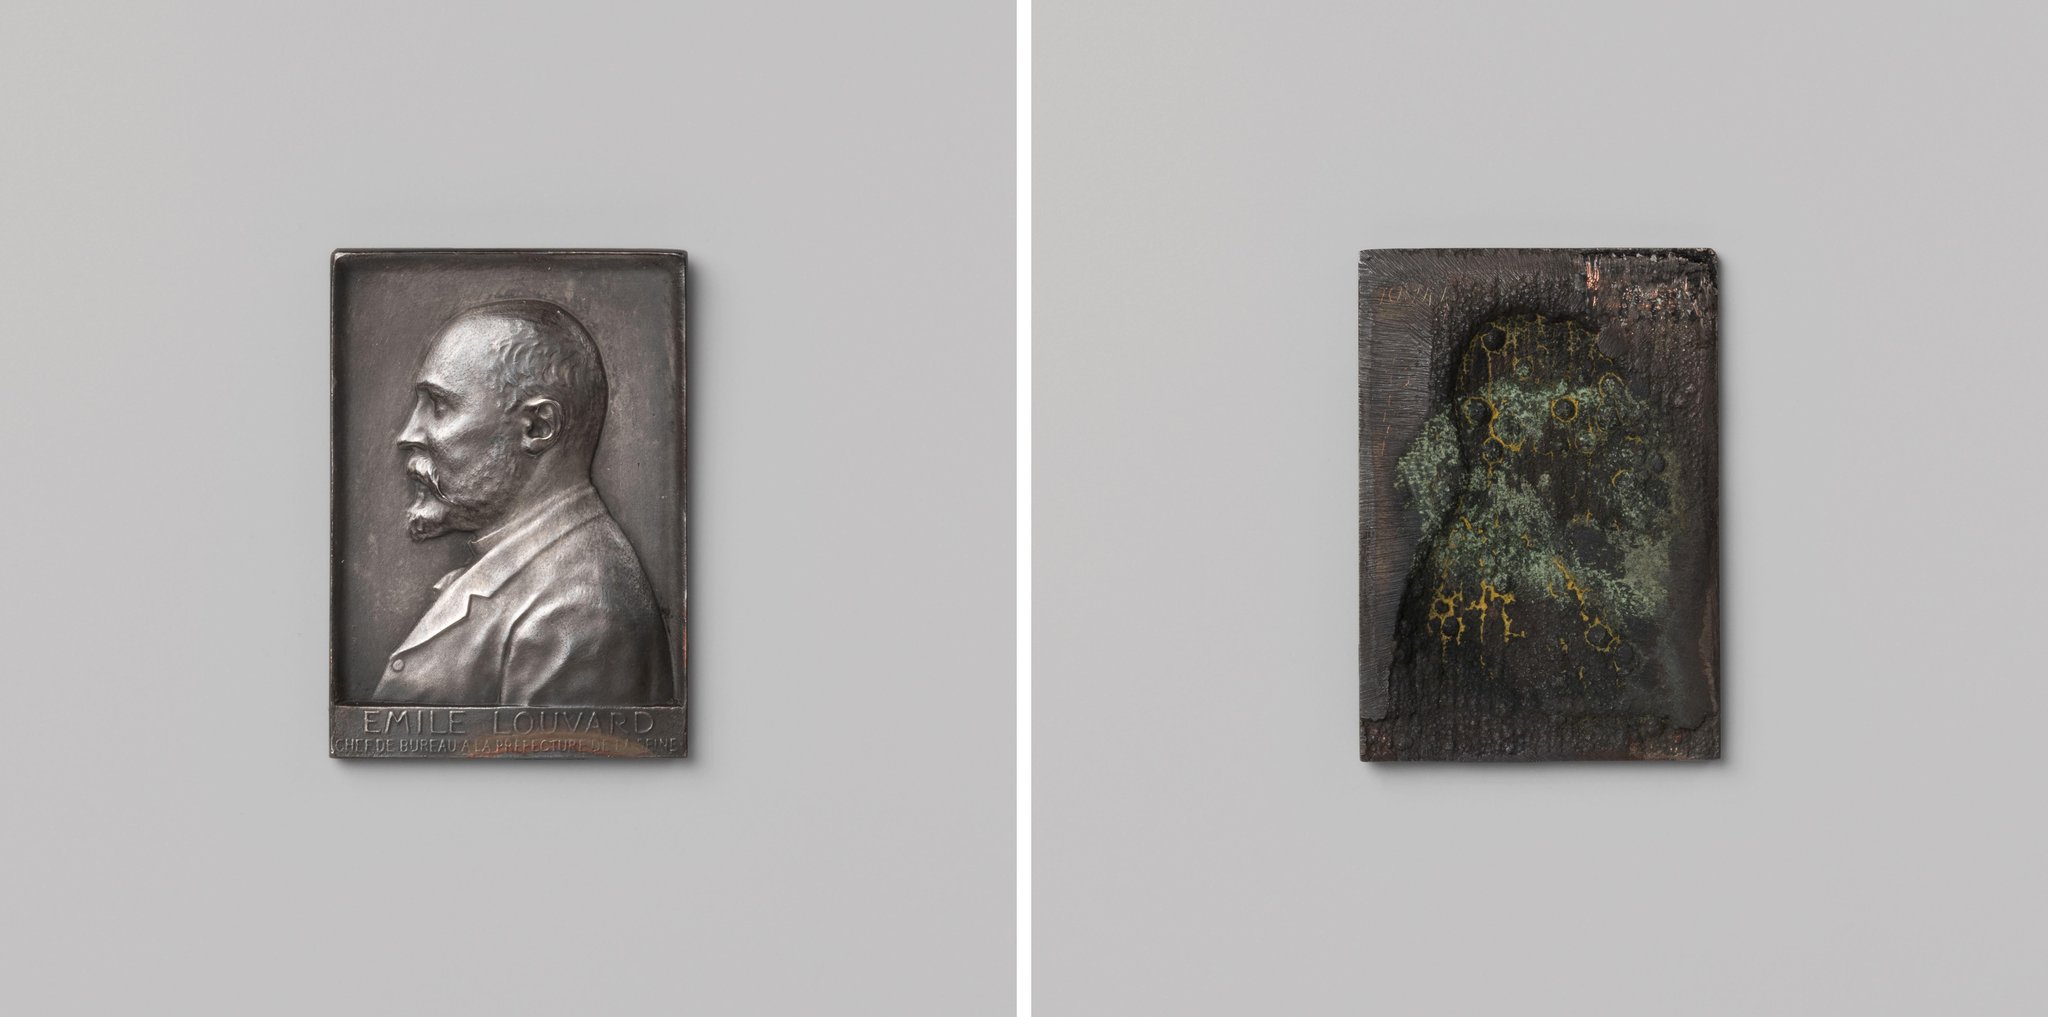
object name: honorary medal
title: Emile Louvard, chef-de-bureau van de prefectuur van de Seine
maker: louis eugène mouchon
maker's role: medailleur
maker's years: 1843-1914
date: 1887-1907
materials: silver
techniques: casting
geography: paris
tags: paris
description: Eenzijdige zilveren rechthoekige penning. Voorzijde: borststuk man; afsnede: opschrift. Keerzijde: blanco.